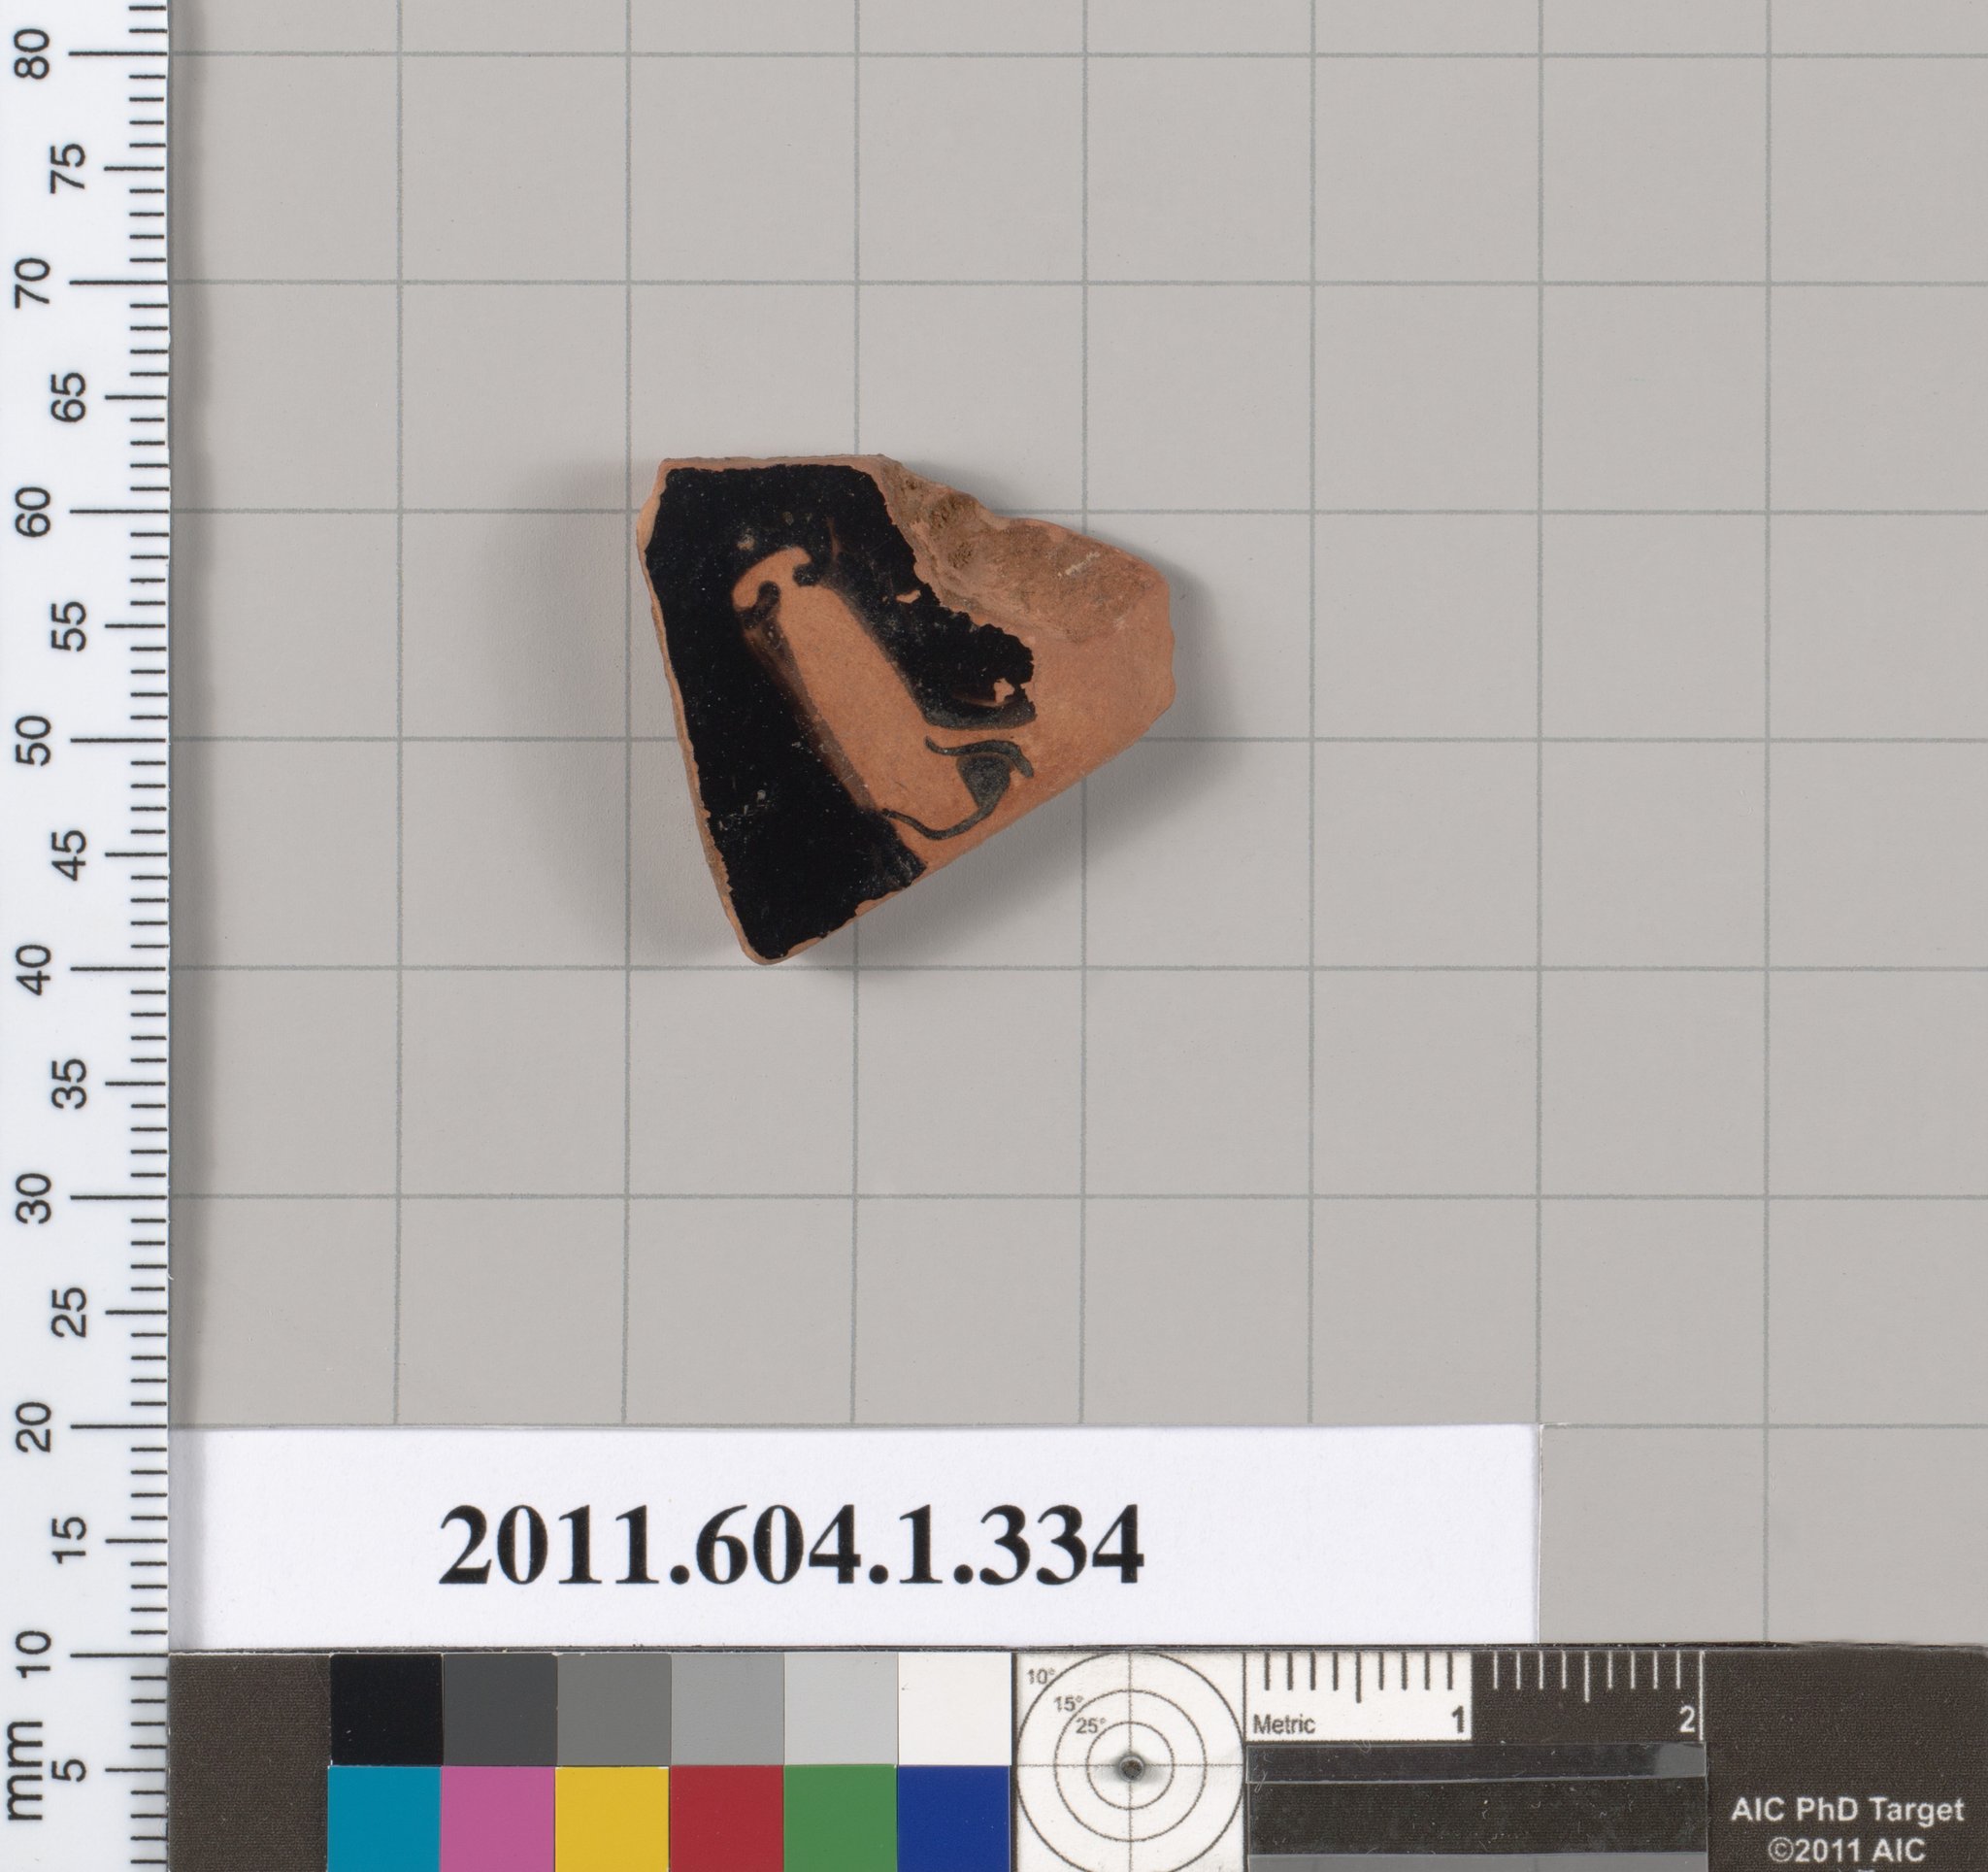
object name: kylix fragment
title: Terracotta fragment of a kylix (drinking cup)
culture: greek, attic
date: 475-451 BCE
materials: terracotta